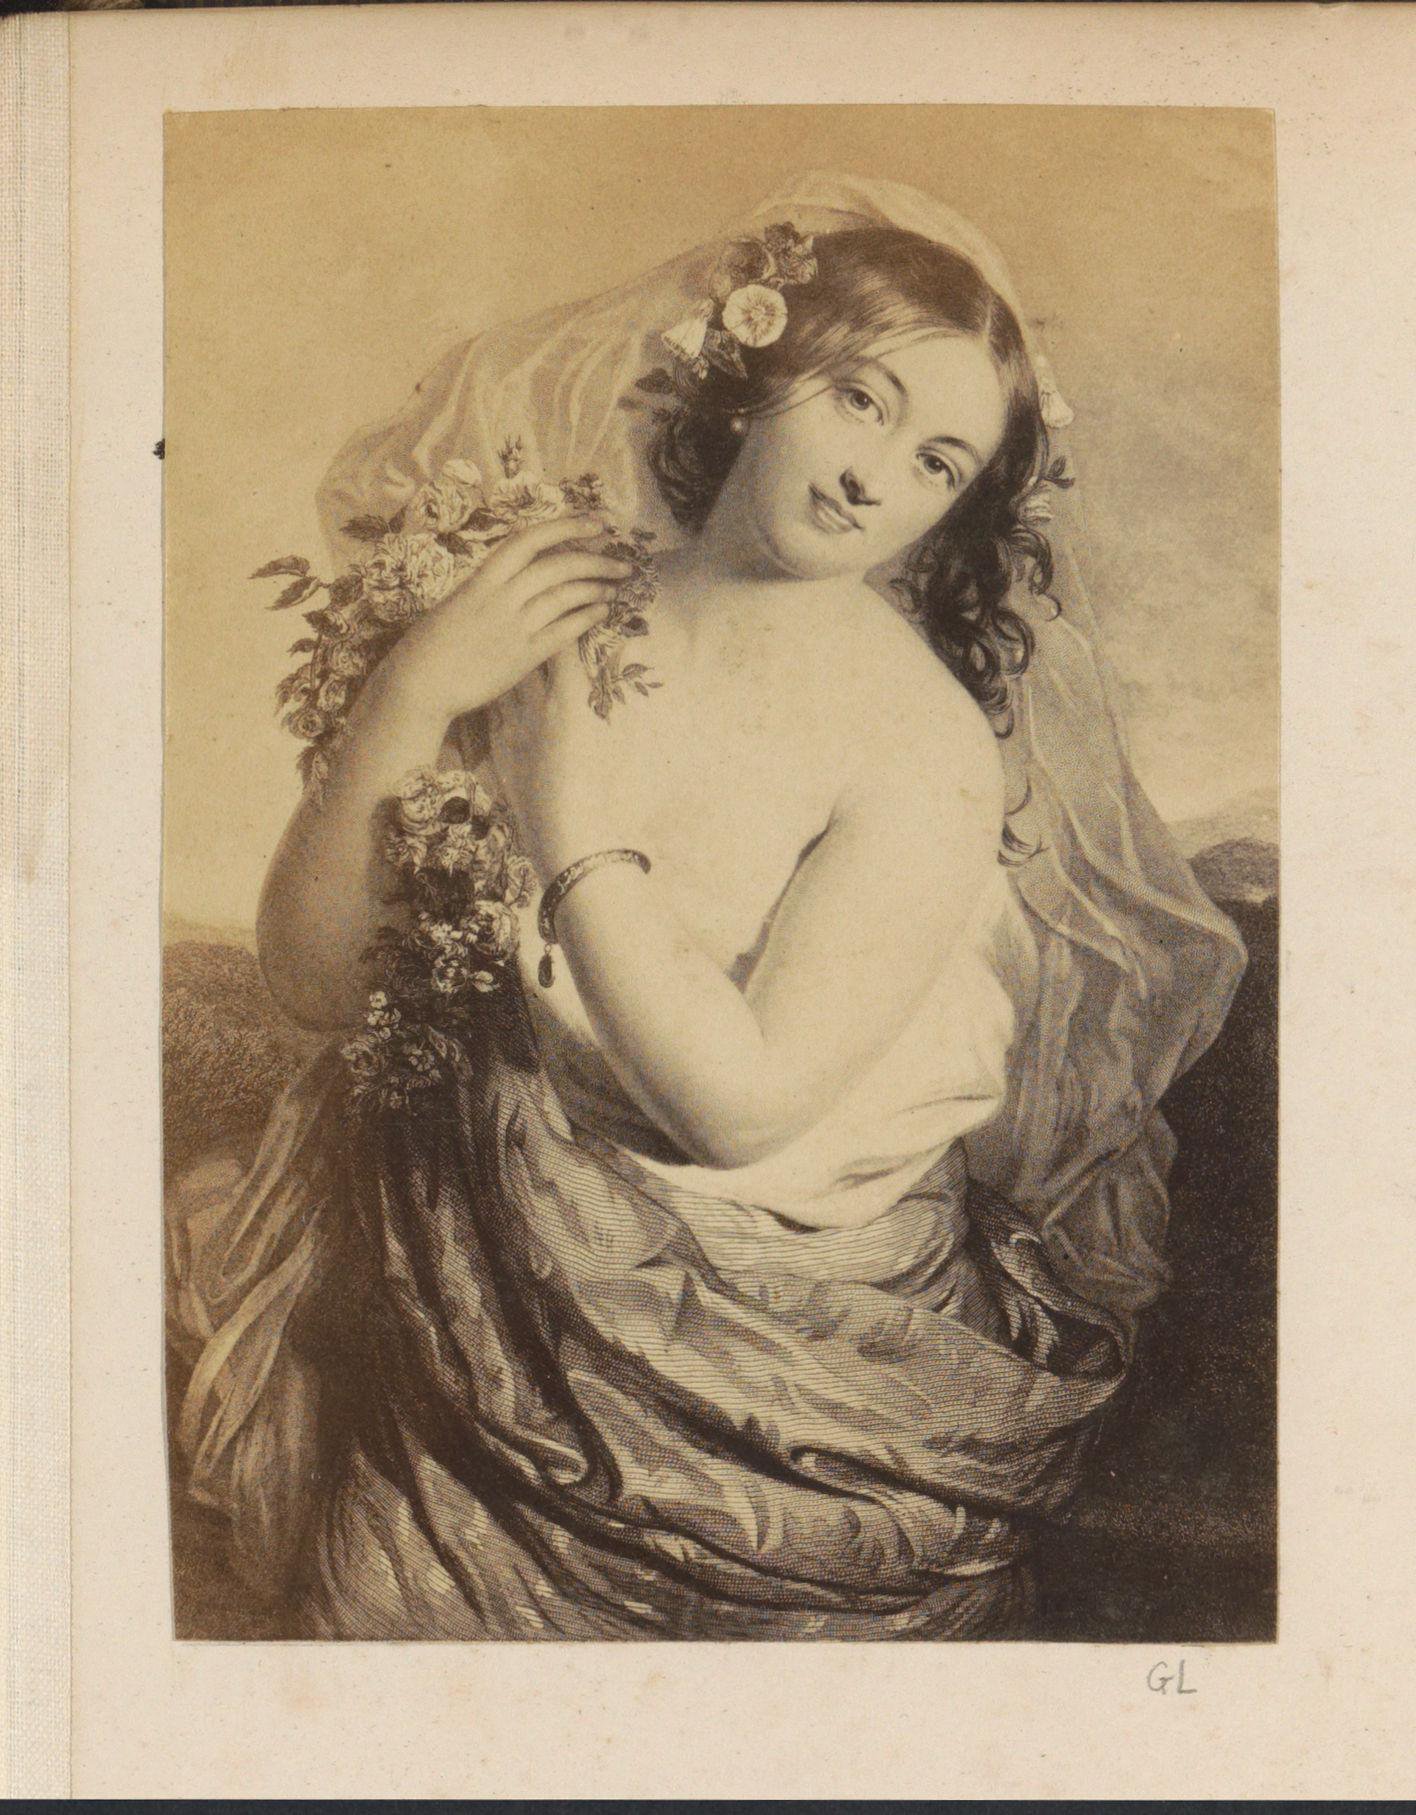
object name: photograph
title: Fotoreproductie van (vermoedelijk) een prent van een jonge vrouw met bloemen in de hand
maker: Anonymous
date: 1850-1870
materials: paper, photographic support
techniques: albumen print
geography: england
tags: adolescent, young woman, maiden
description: Onderdeel van Album met foto's van bezienswaardigheden en landschappen in Engeland en van kunst.